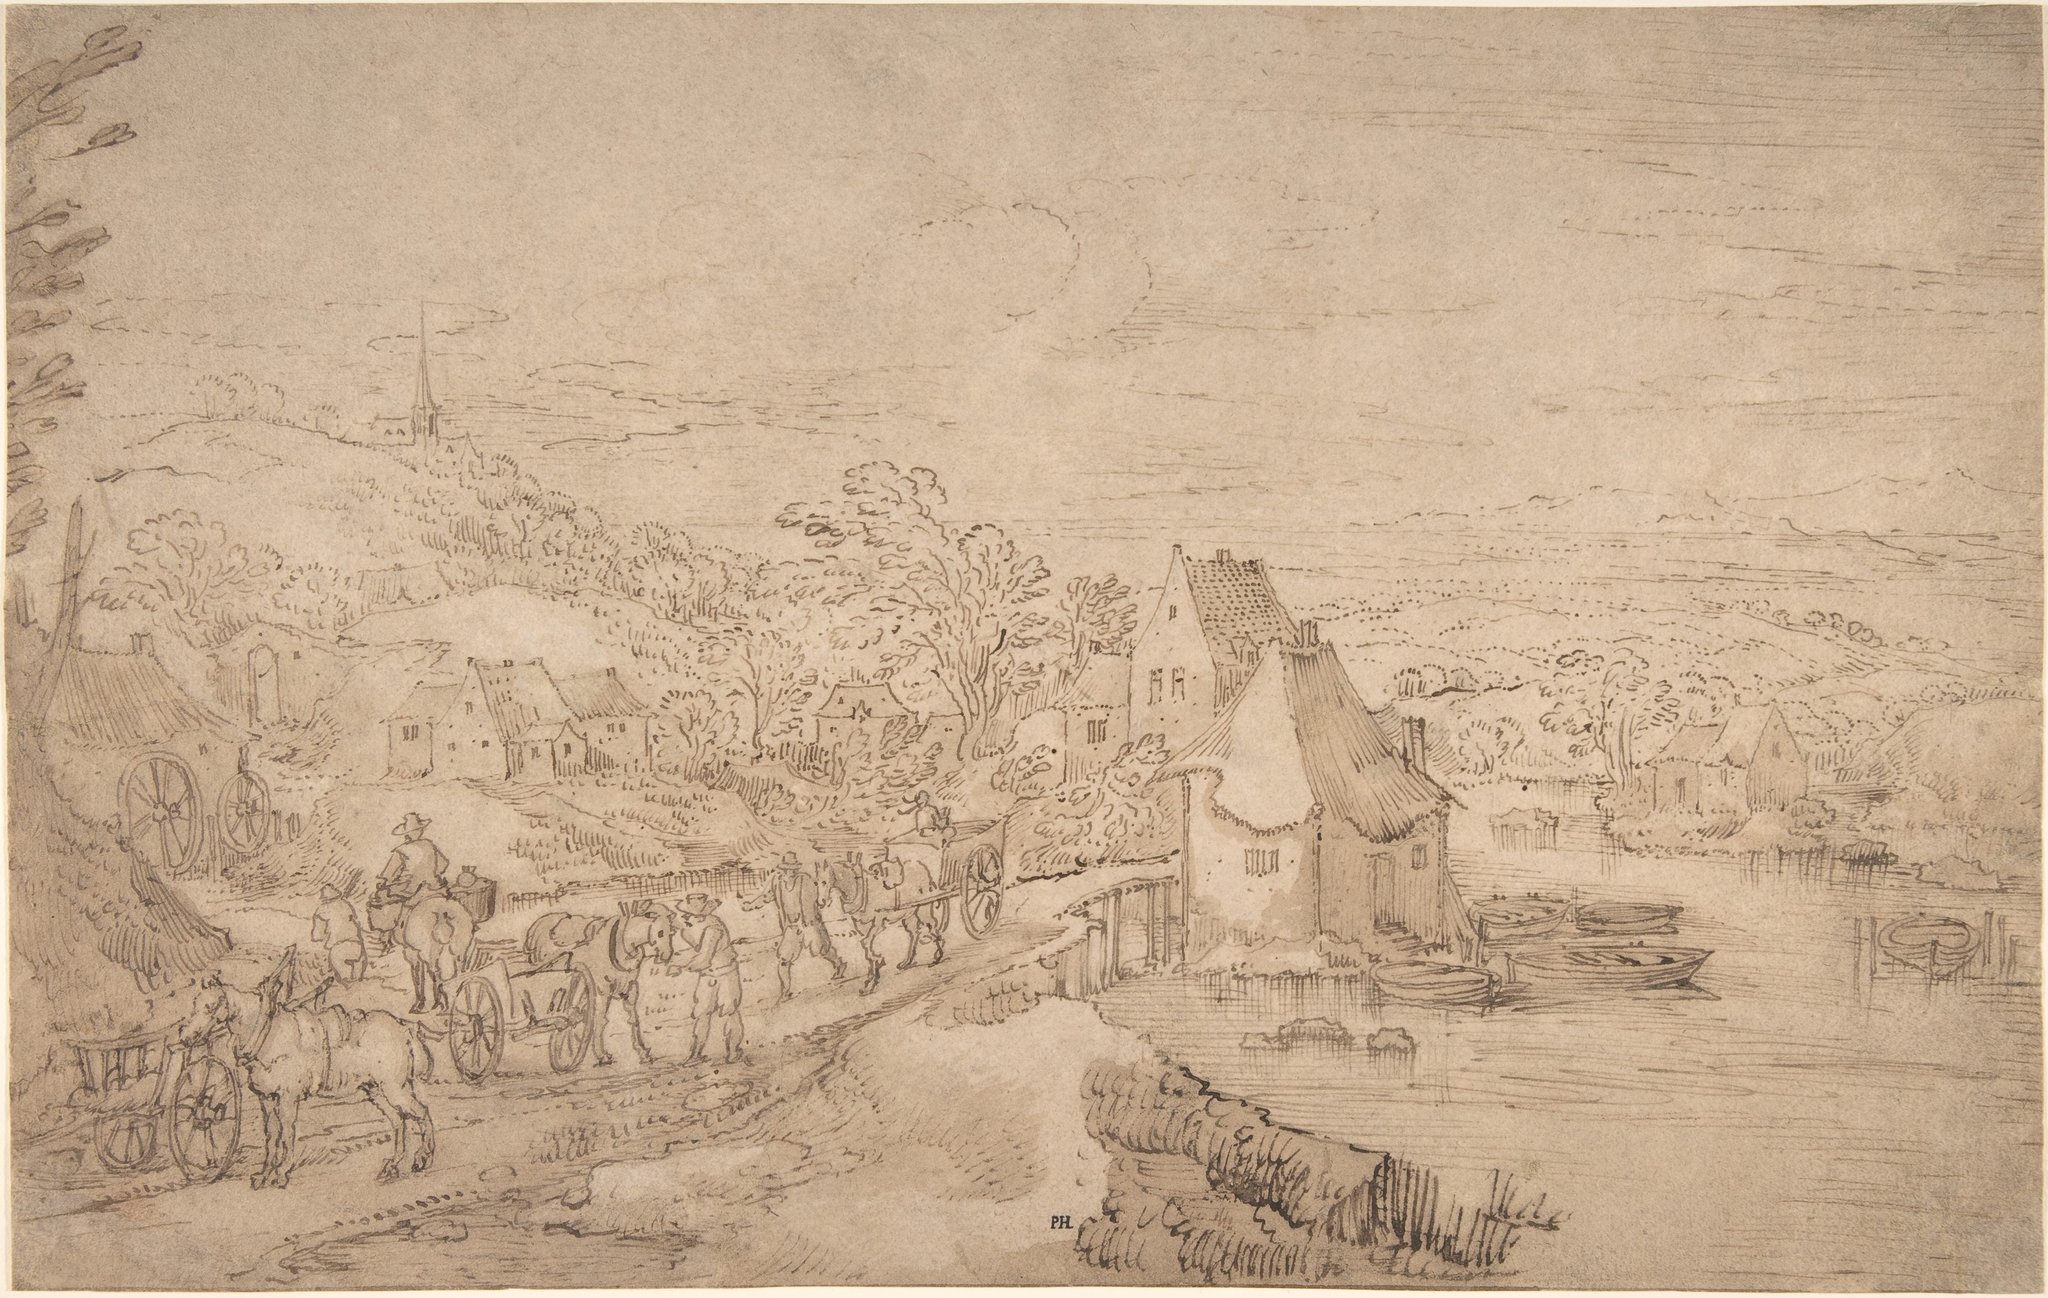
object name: drawing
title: River Landscape with Wagons on a Road near a Village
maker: joos de momper the younger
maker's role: artist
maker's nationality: netherlandish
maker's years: 1564-1635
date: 1586-1631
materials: chalk, ink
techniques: pen, wash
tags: houses,roads,villages,rivers,landscapes